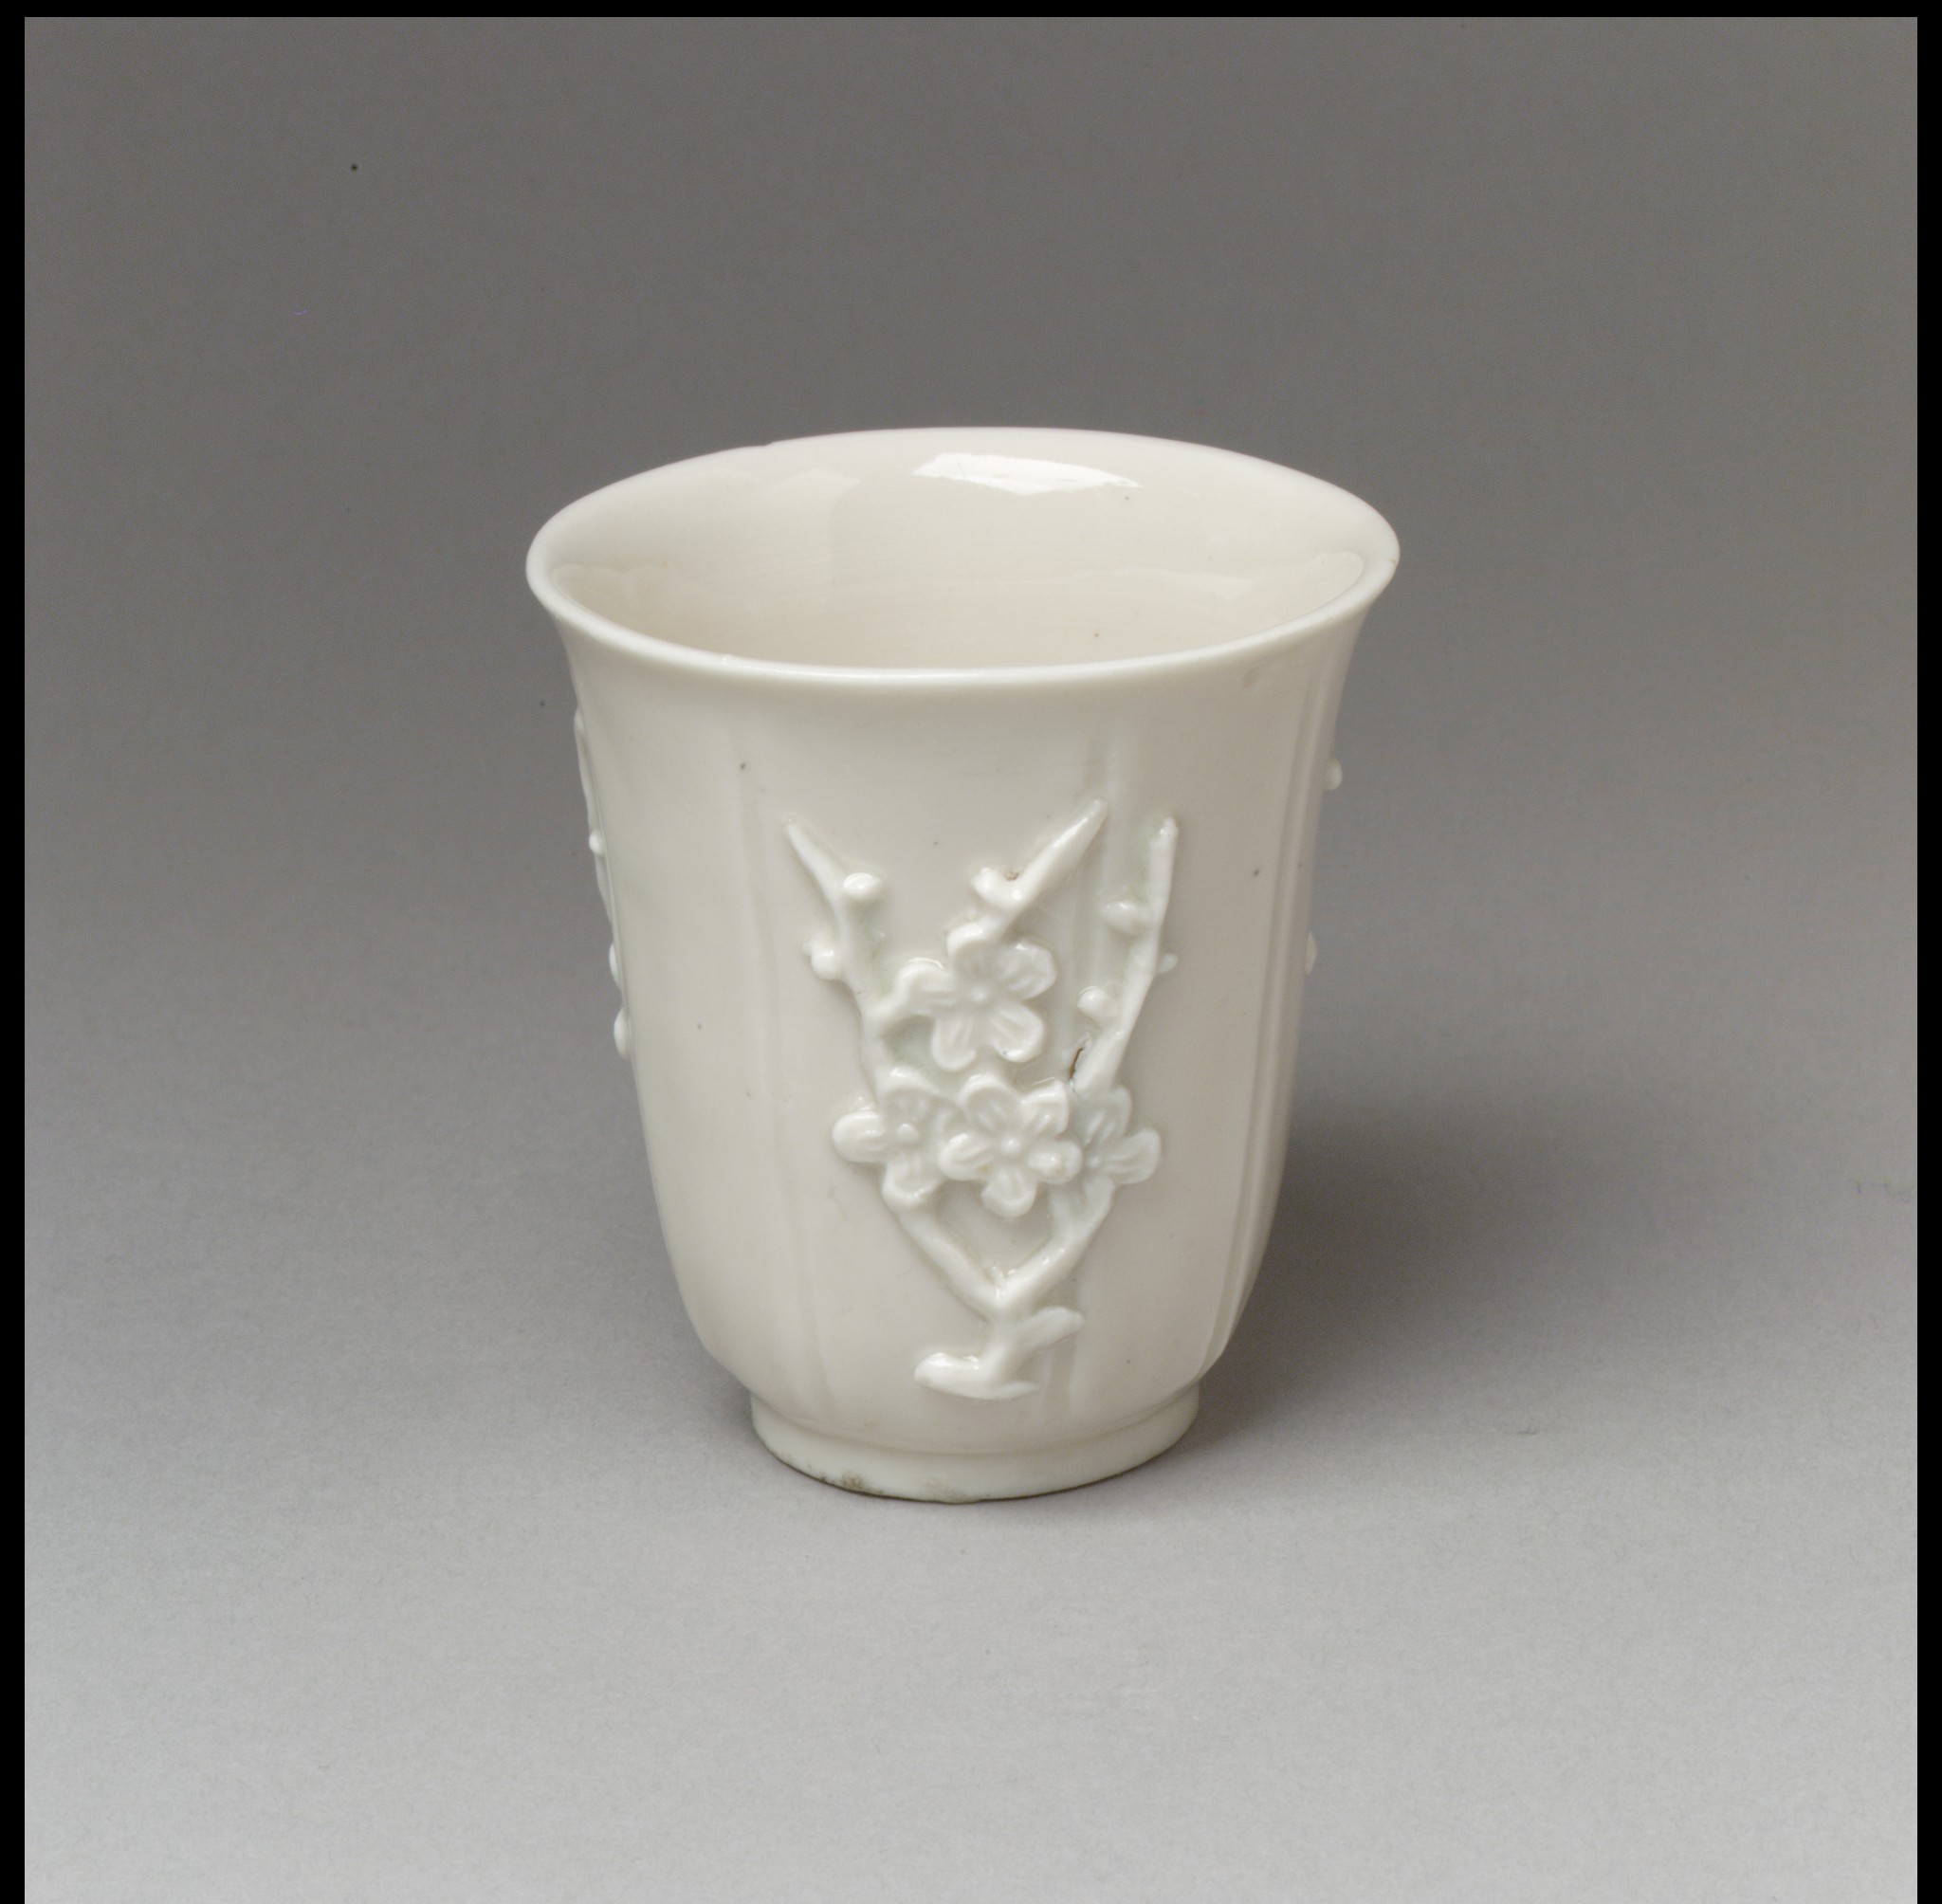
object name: beaker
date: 1601-1700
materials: hard paste porcelain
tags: flowers